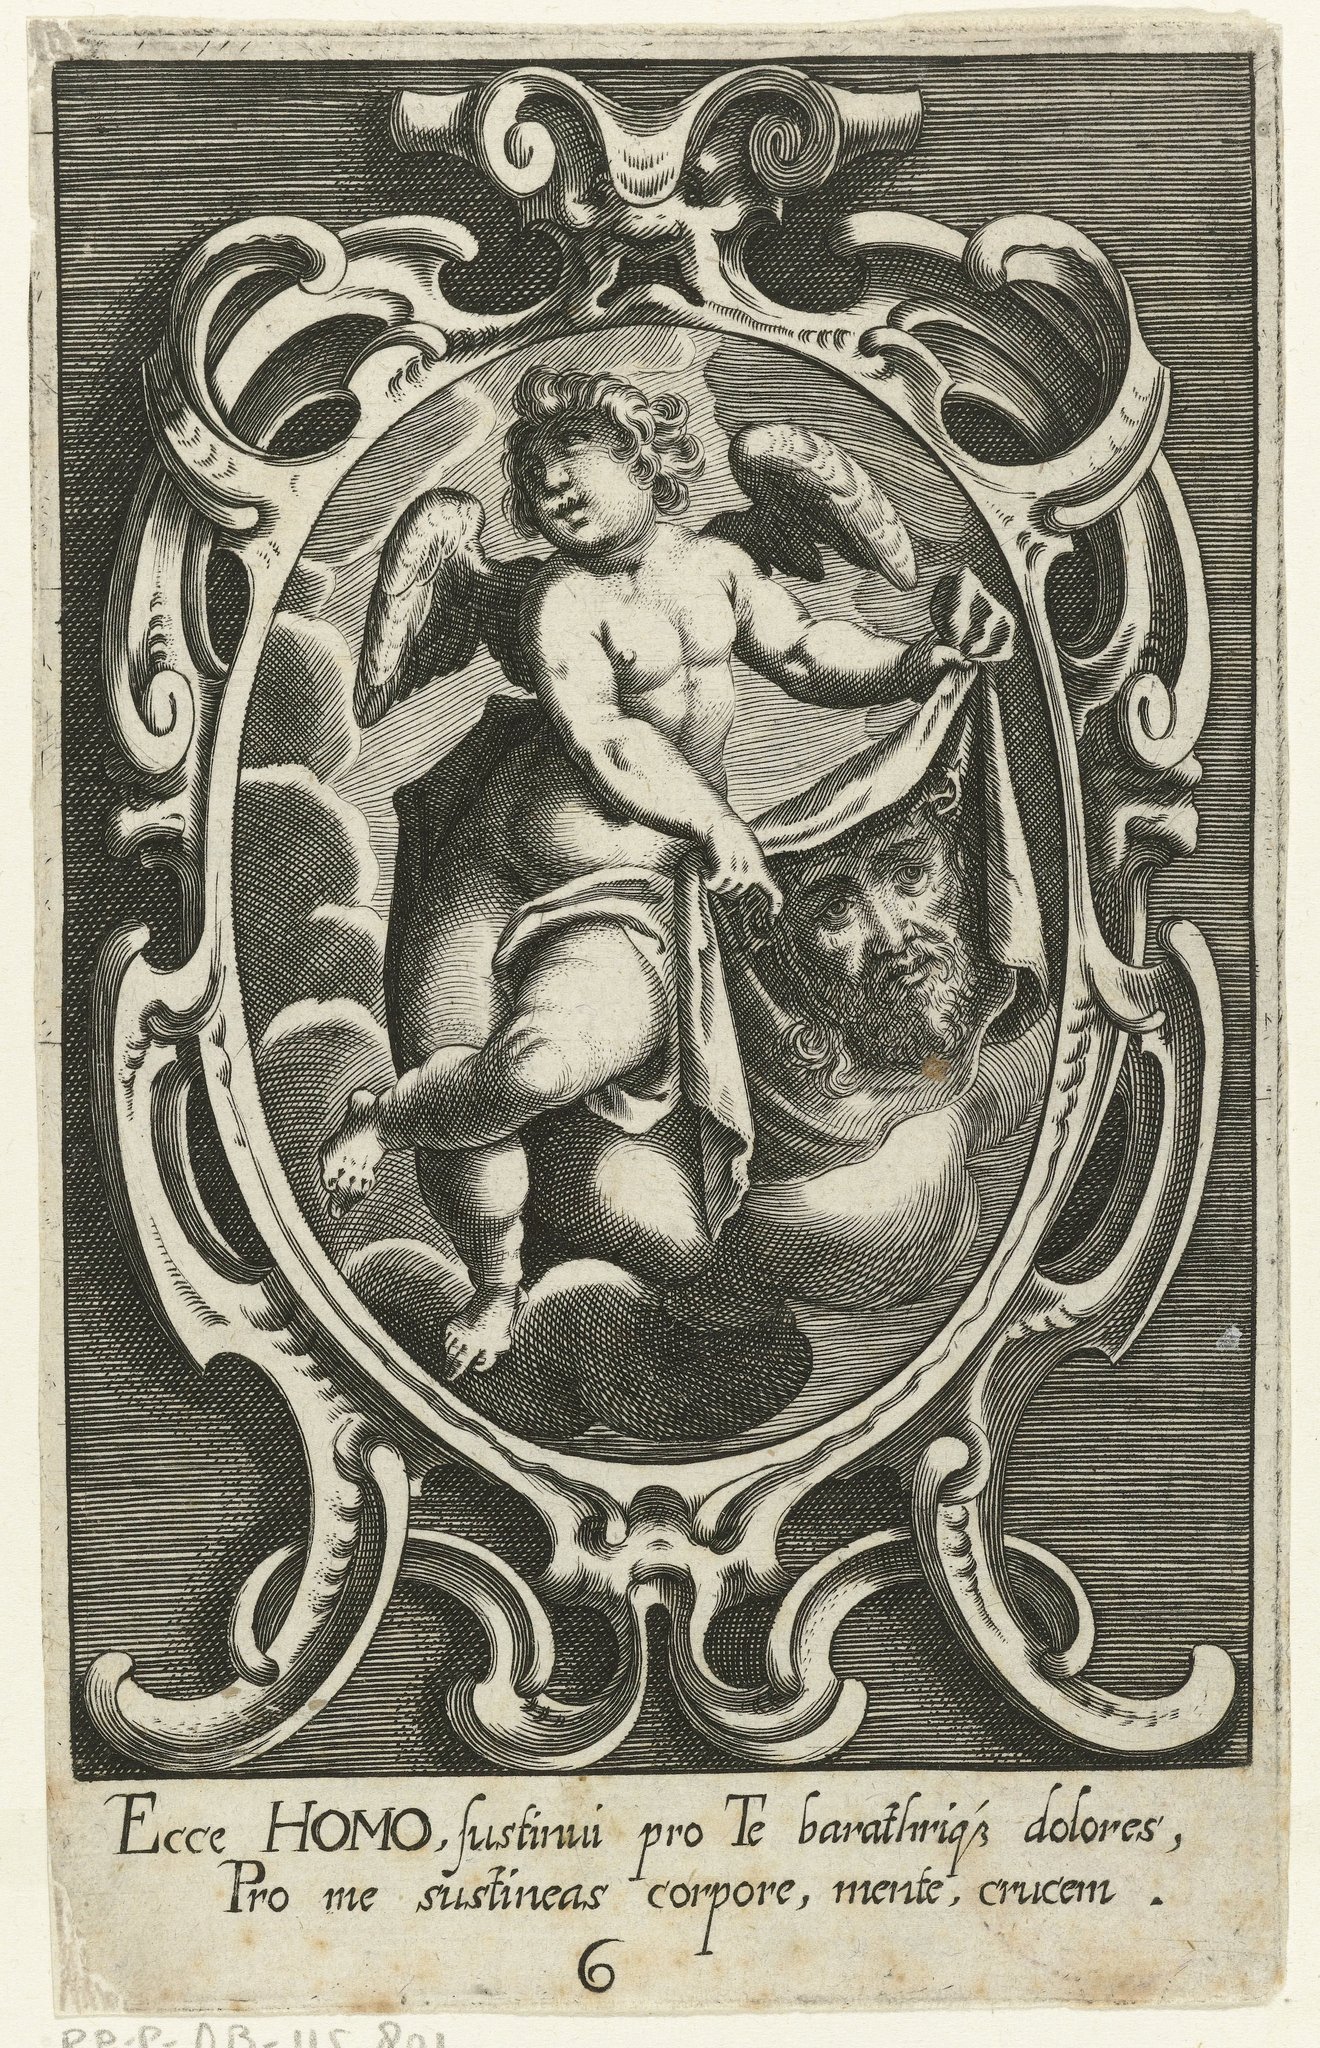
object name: print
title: De passiewerktuigen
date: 1620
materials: paper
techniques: engraving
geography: augsburg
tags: 'arma christi', shroud ~ instruments of the passion, 'vera icon', 'sudarium', veronica-portrait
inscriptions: collector's mark: Lugt 240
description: Serie bevattende een titelprent en elf prenten van de passiewerktuigen. De prenten zijn genummerd van één tot en met twaalf. Nummer tien is niet aanwezig in deze serie, evenals in de series genoemd in de referentielitertuur.